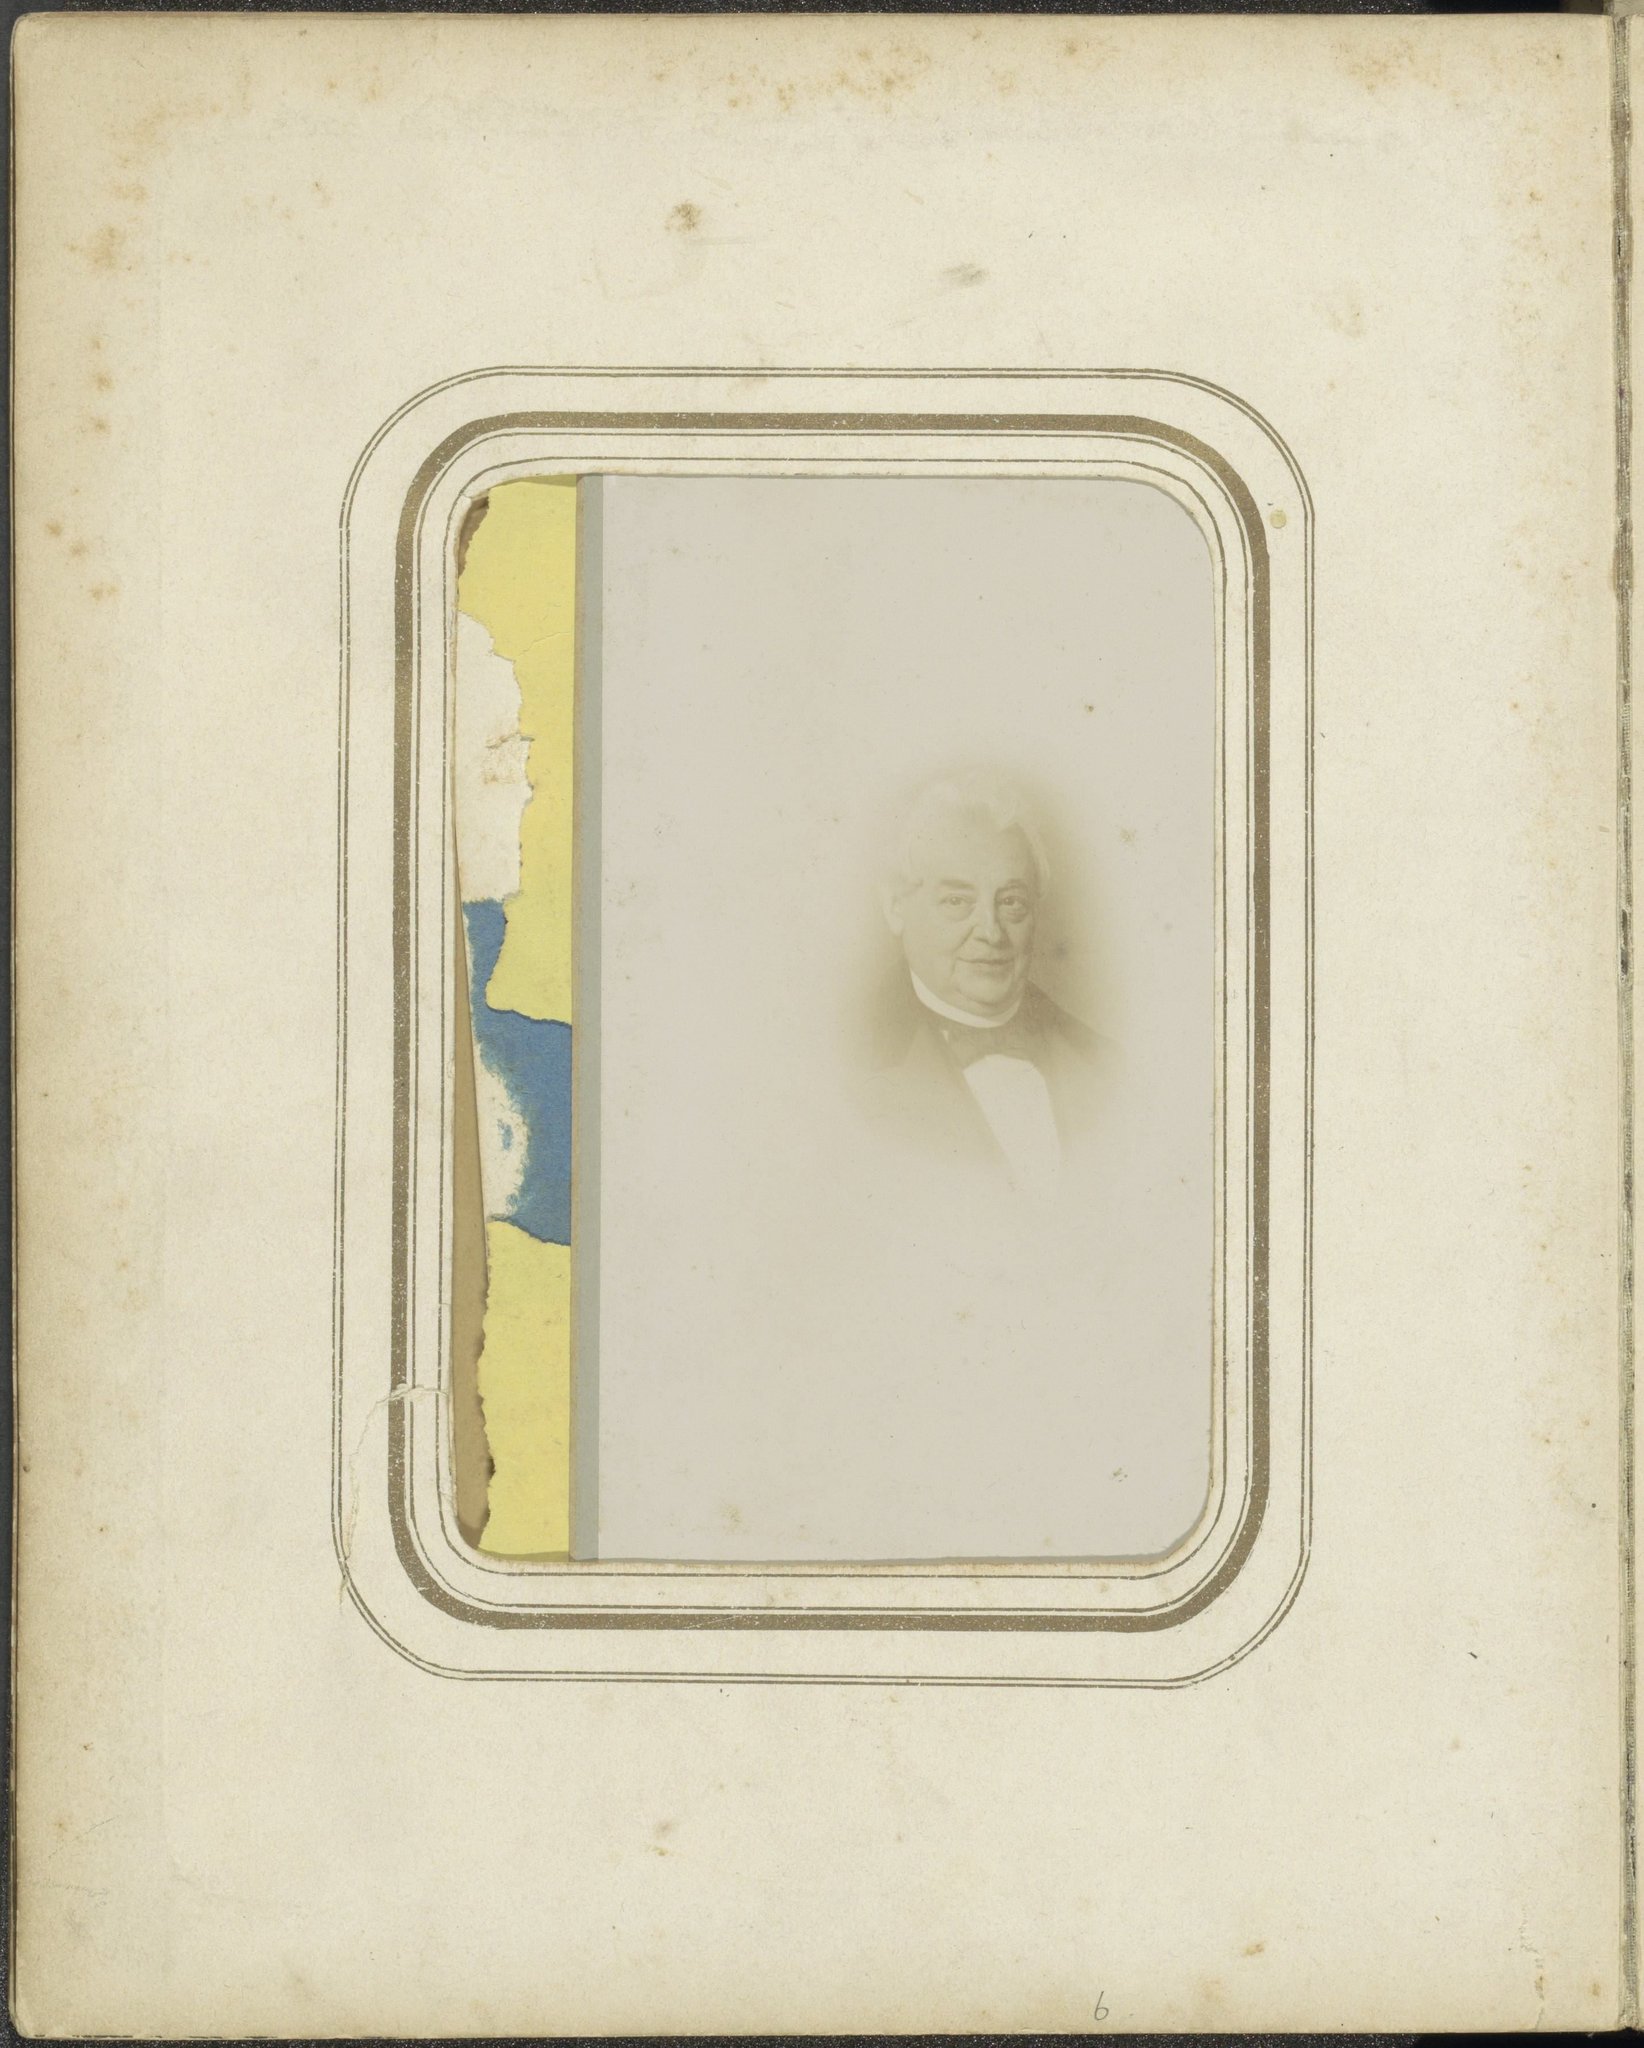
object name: cabinet photograph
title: Portret van een man met een strikje, mogelijk A.J. Swart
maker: Anonymous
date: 1895-1905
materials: cardboard, photographic support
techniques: collodion silver print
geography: netherlands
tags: amsterdam, the hague, historical persons, neck-gear ~ clothing, family, relationship, descent, netherlands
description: Onderdeel van Familiealbum van H.W.F. Ligtenberg en L.M. Swart met 149 foto's en cartes-de-visite.